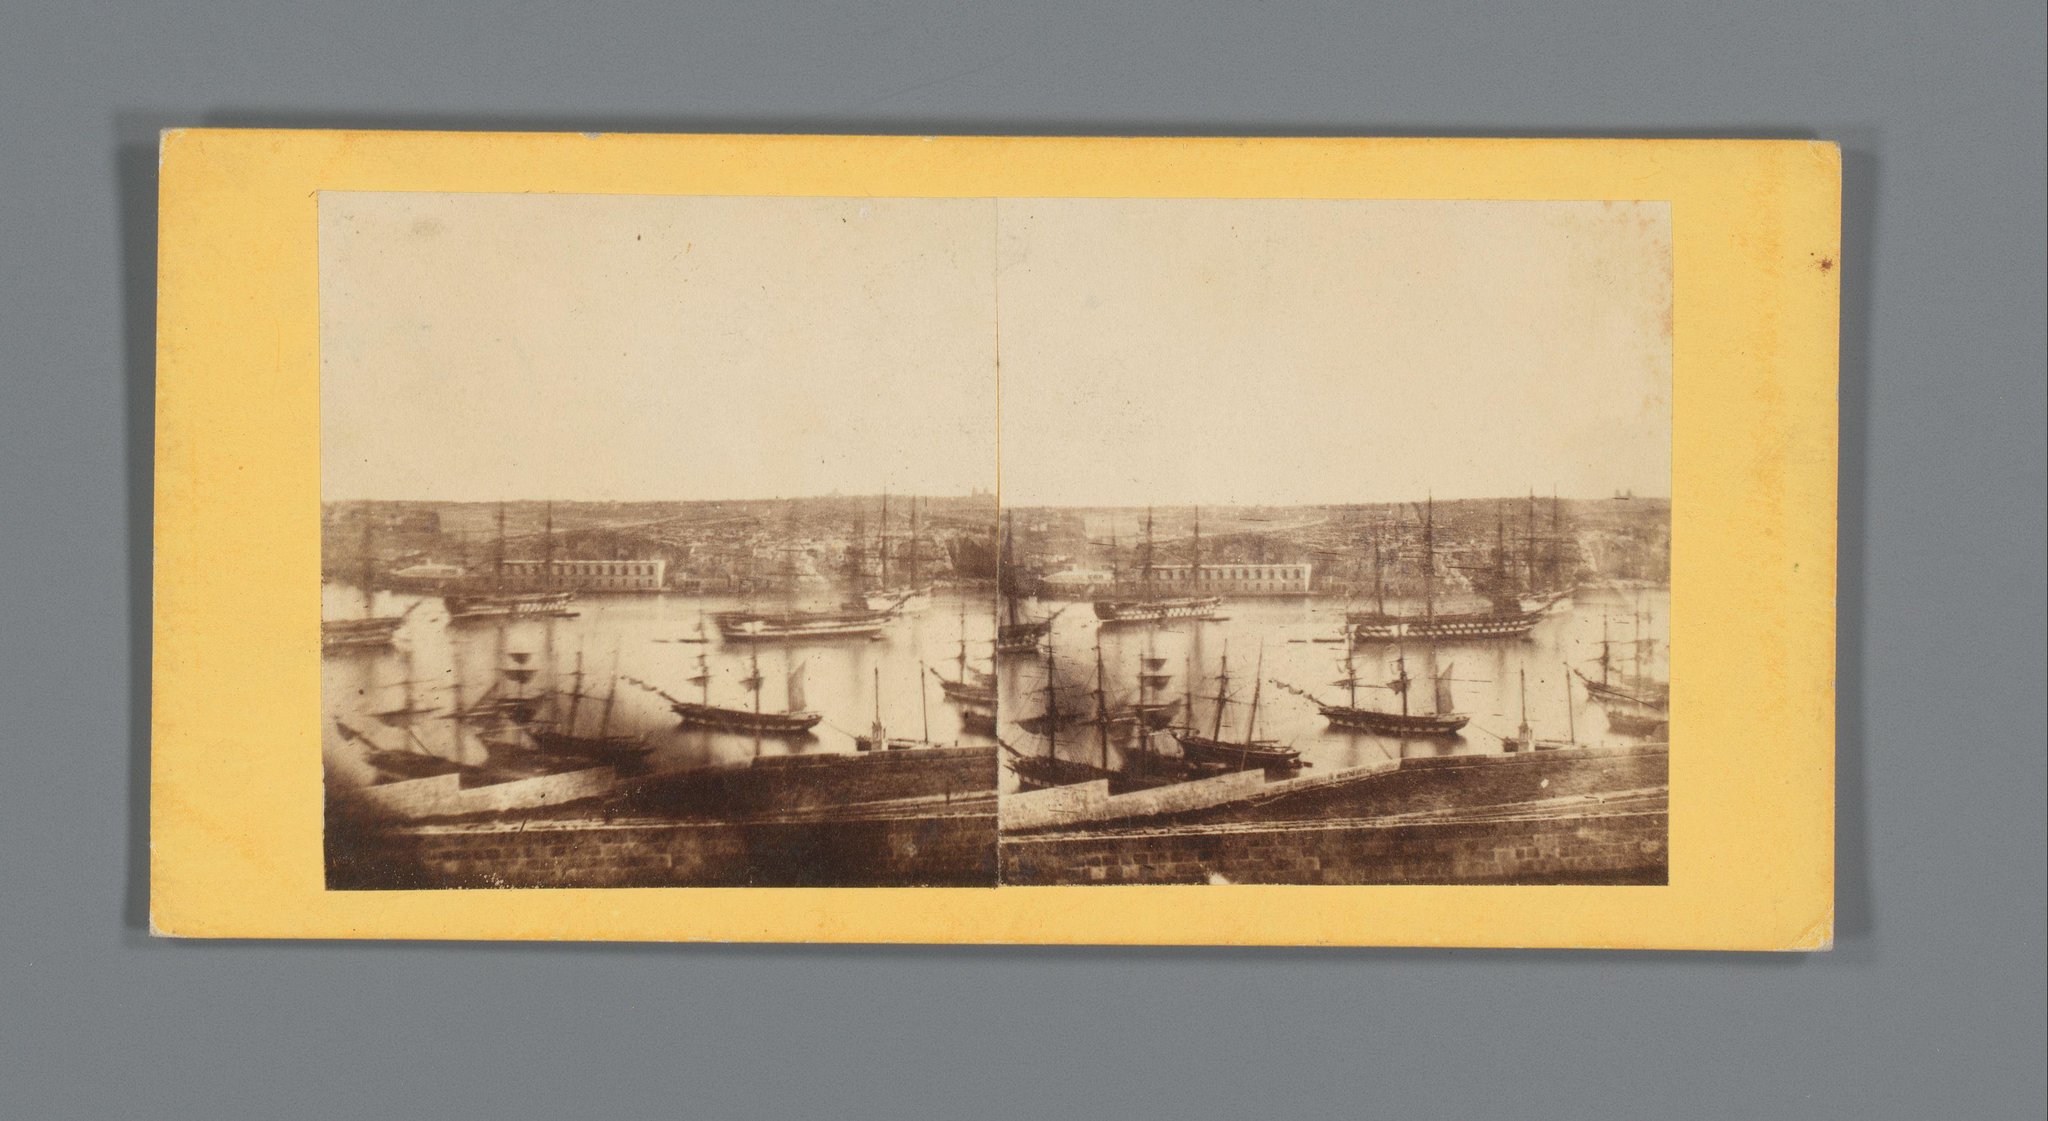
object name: stereograph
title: Britse vloot in de haven van Malta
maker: Anonymous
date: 1861-1870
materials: cardboard, paper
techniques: albumen print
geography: malta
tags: harbour, ship's portrait - cc - more than one ship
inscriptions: inscription: ‘F. 3.’